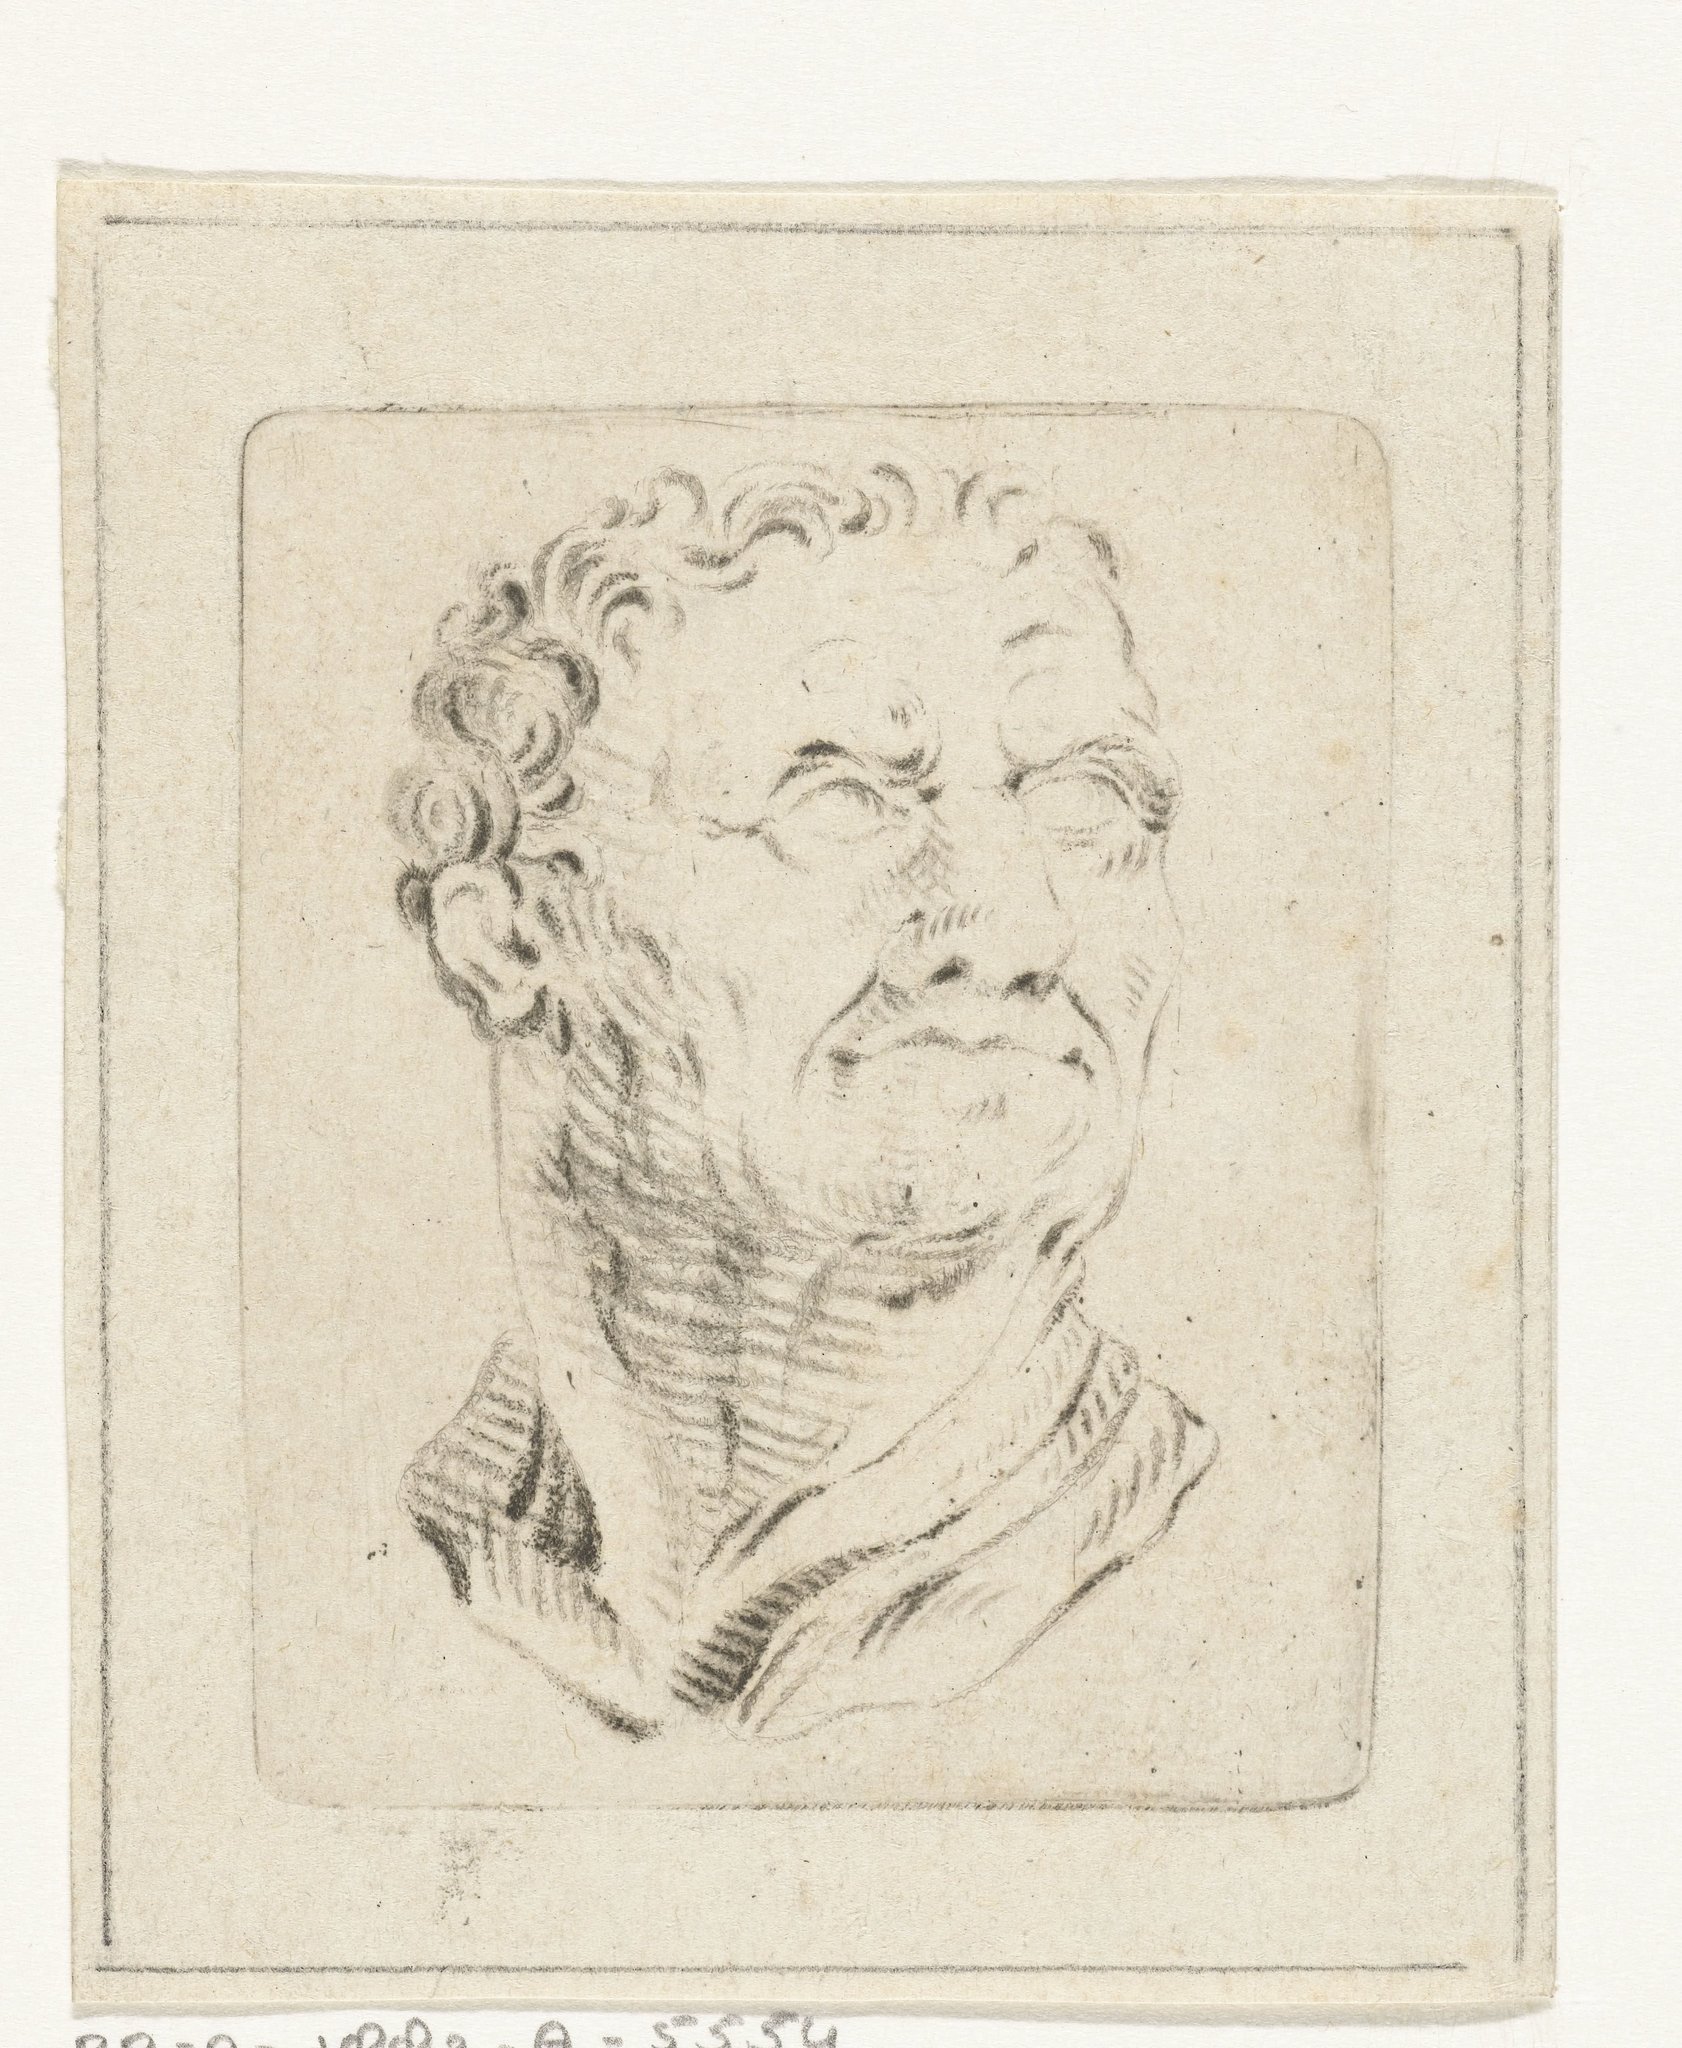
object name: print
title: Borstbeeld van een man opkijkend naar rechts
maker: joannis jacobus bijlaert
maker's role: draughtsman, print maker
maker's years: 1734-1809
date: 1749-1809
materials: paper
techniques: printmaking, etching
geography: leiden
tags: adult man, classical history (+ (full) bust)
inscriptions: collector's mark: Lugt 2228